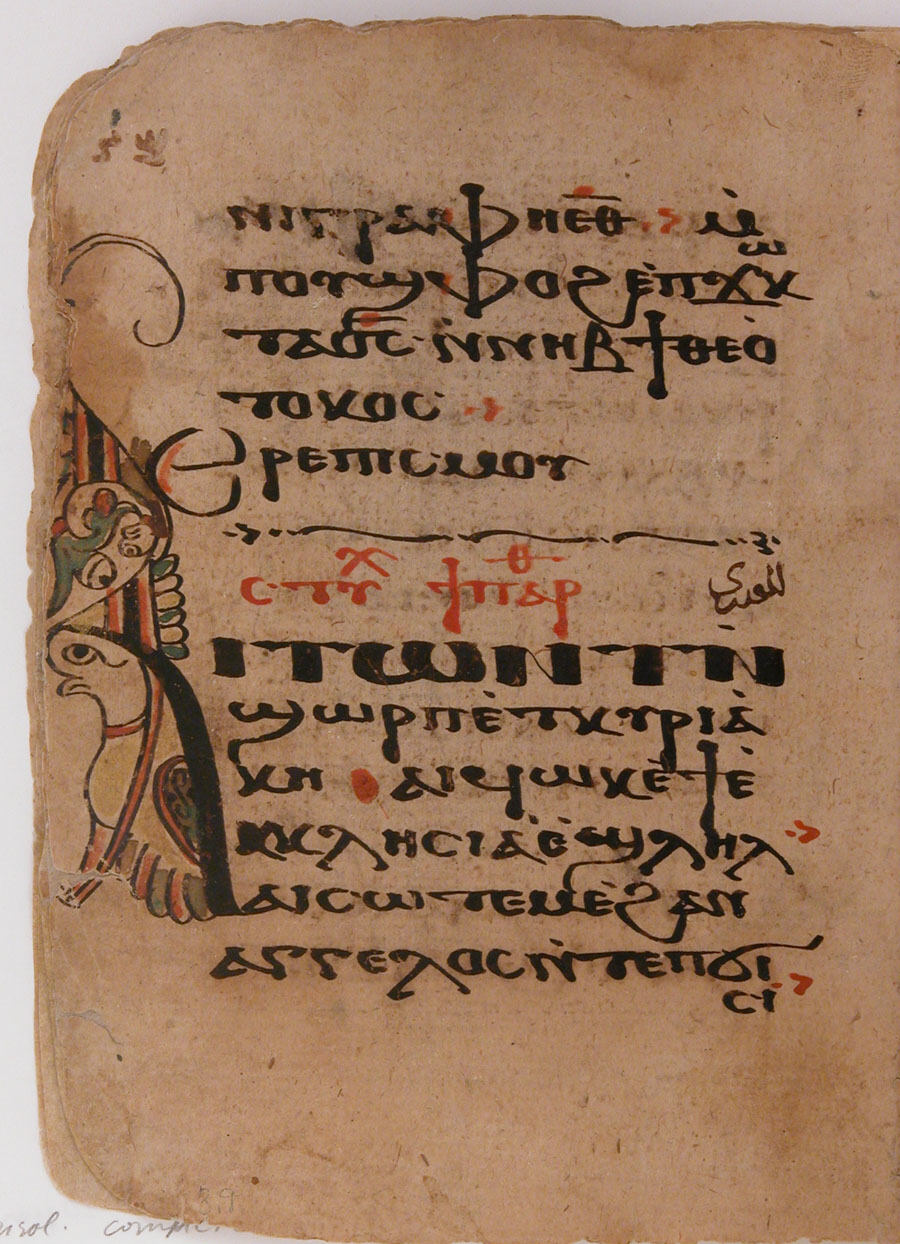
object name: non illustrated manuscript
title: Coptic Manuscript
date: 201-1200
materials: ink, paper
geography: egypt